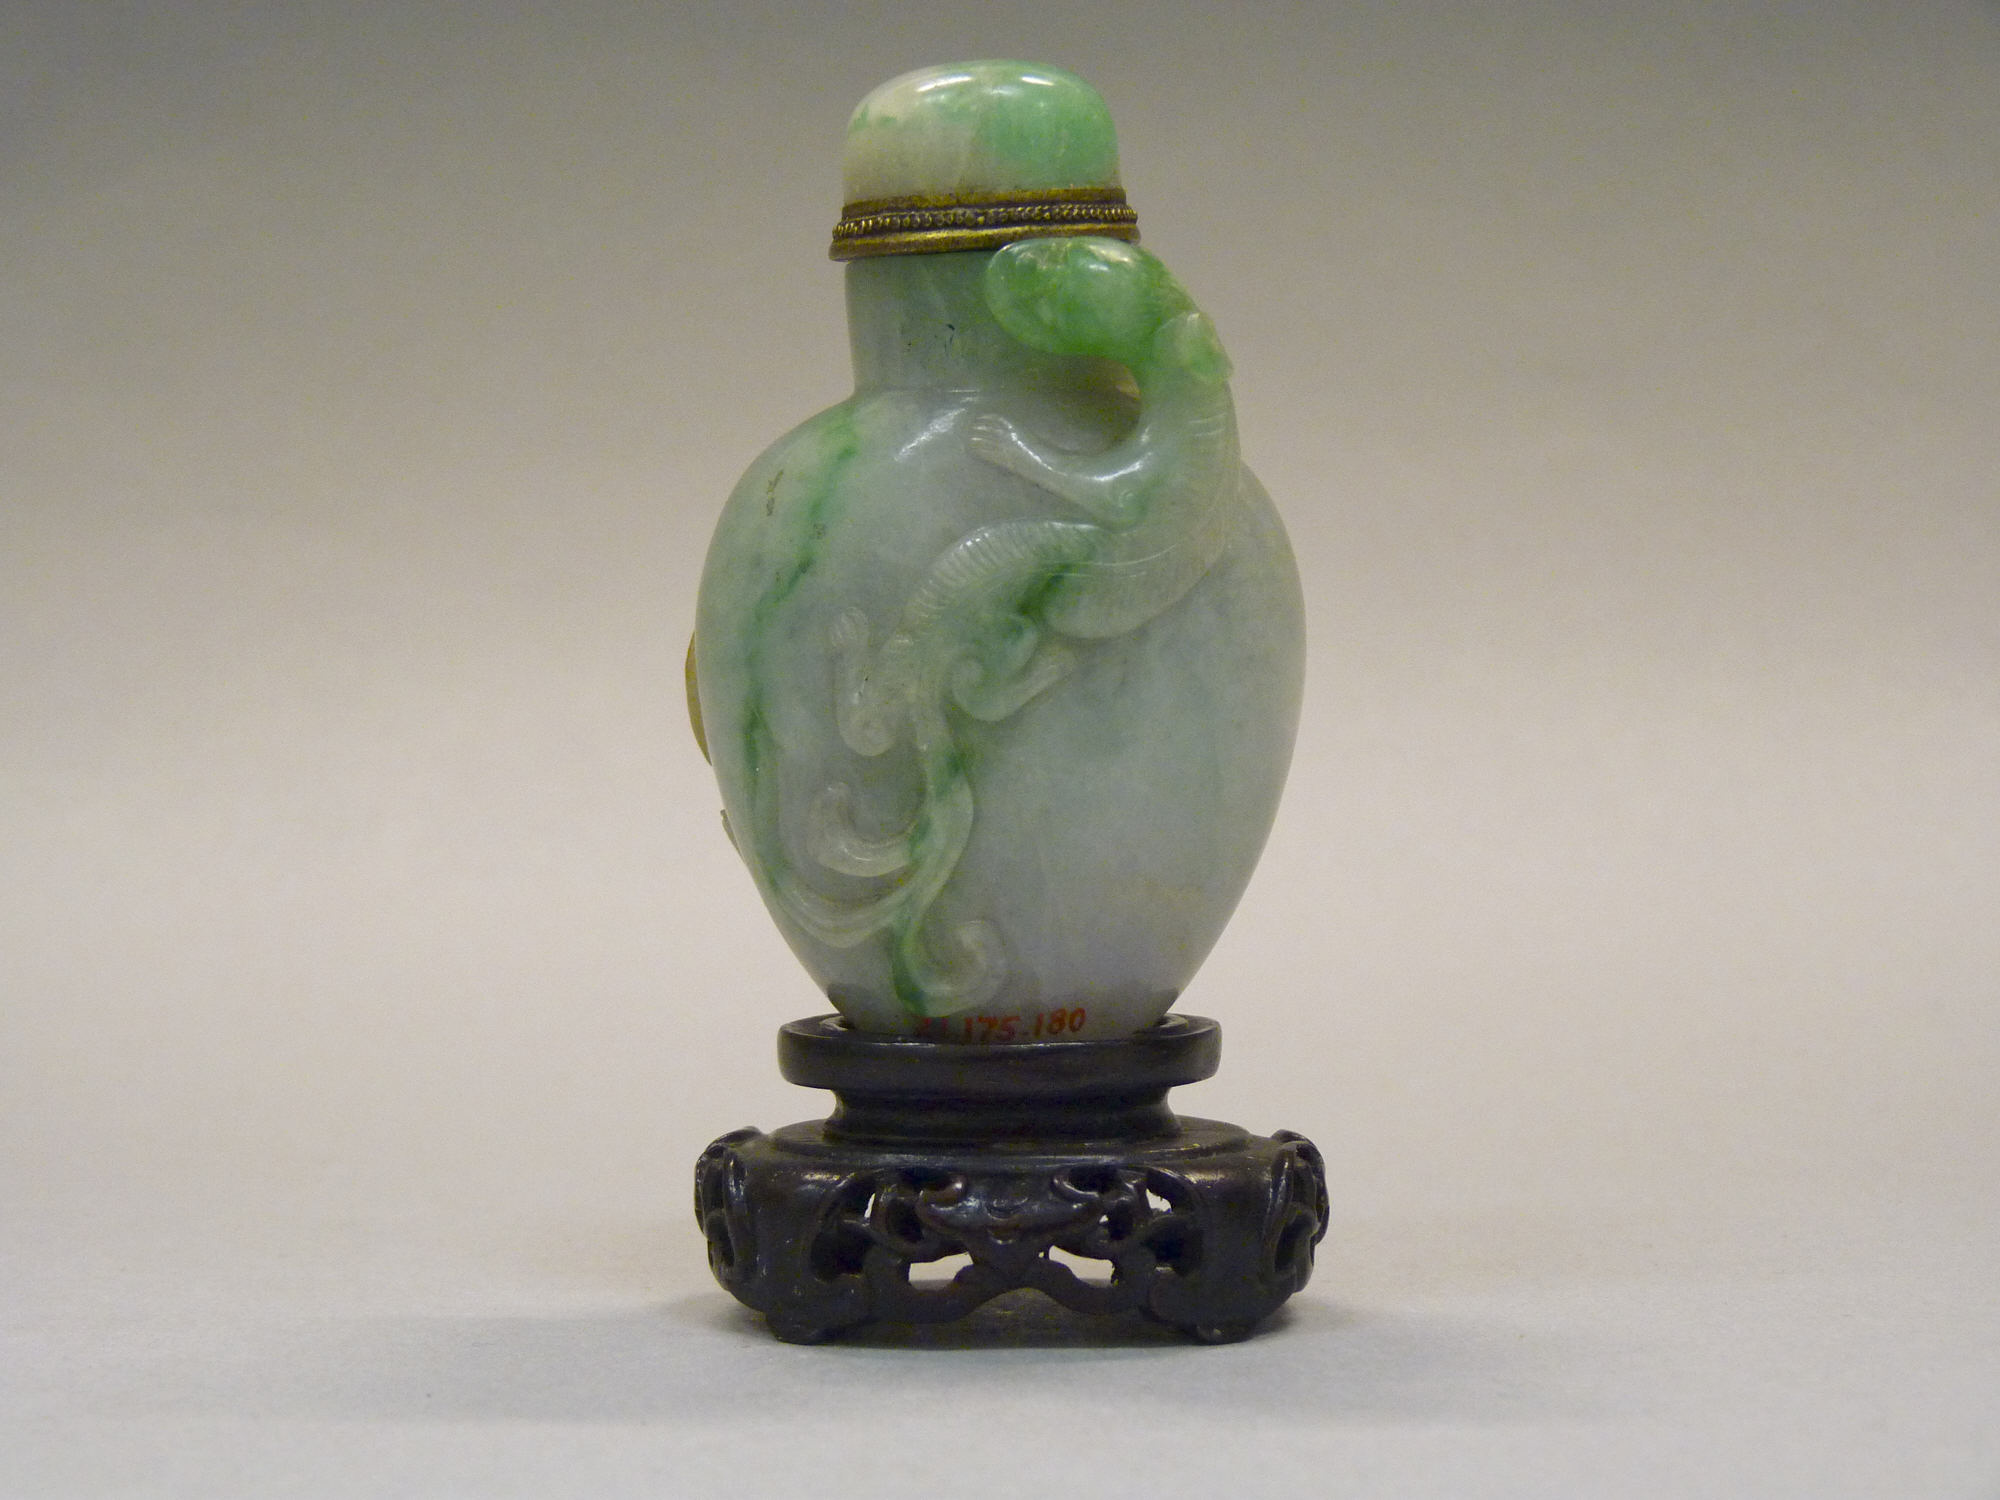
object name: snuff bottle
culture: chinese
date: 1736-1795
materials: jade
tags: lizards